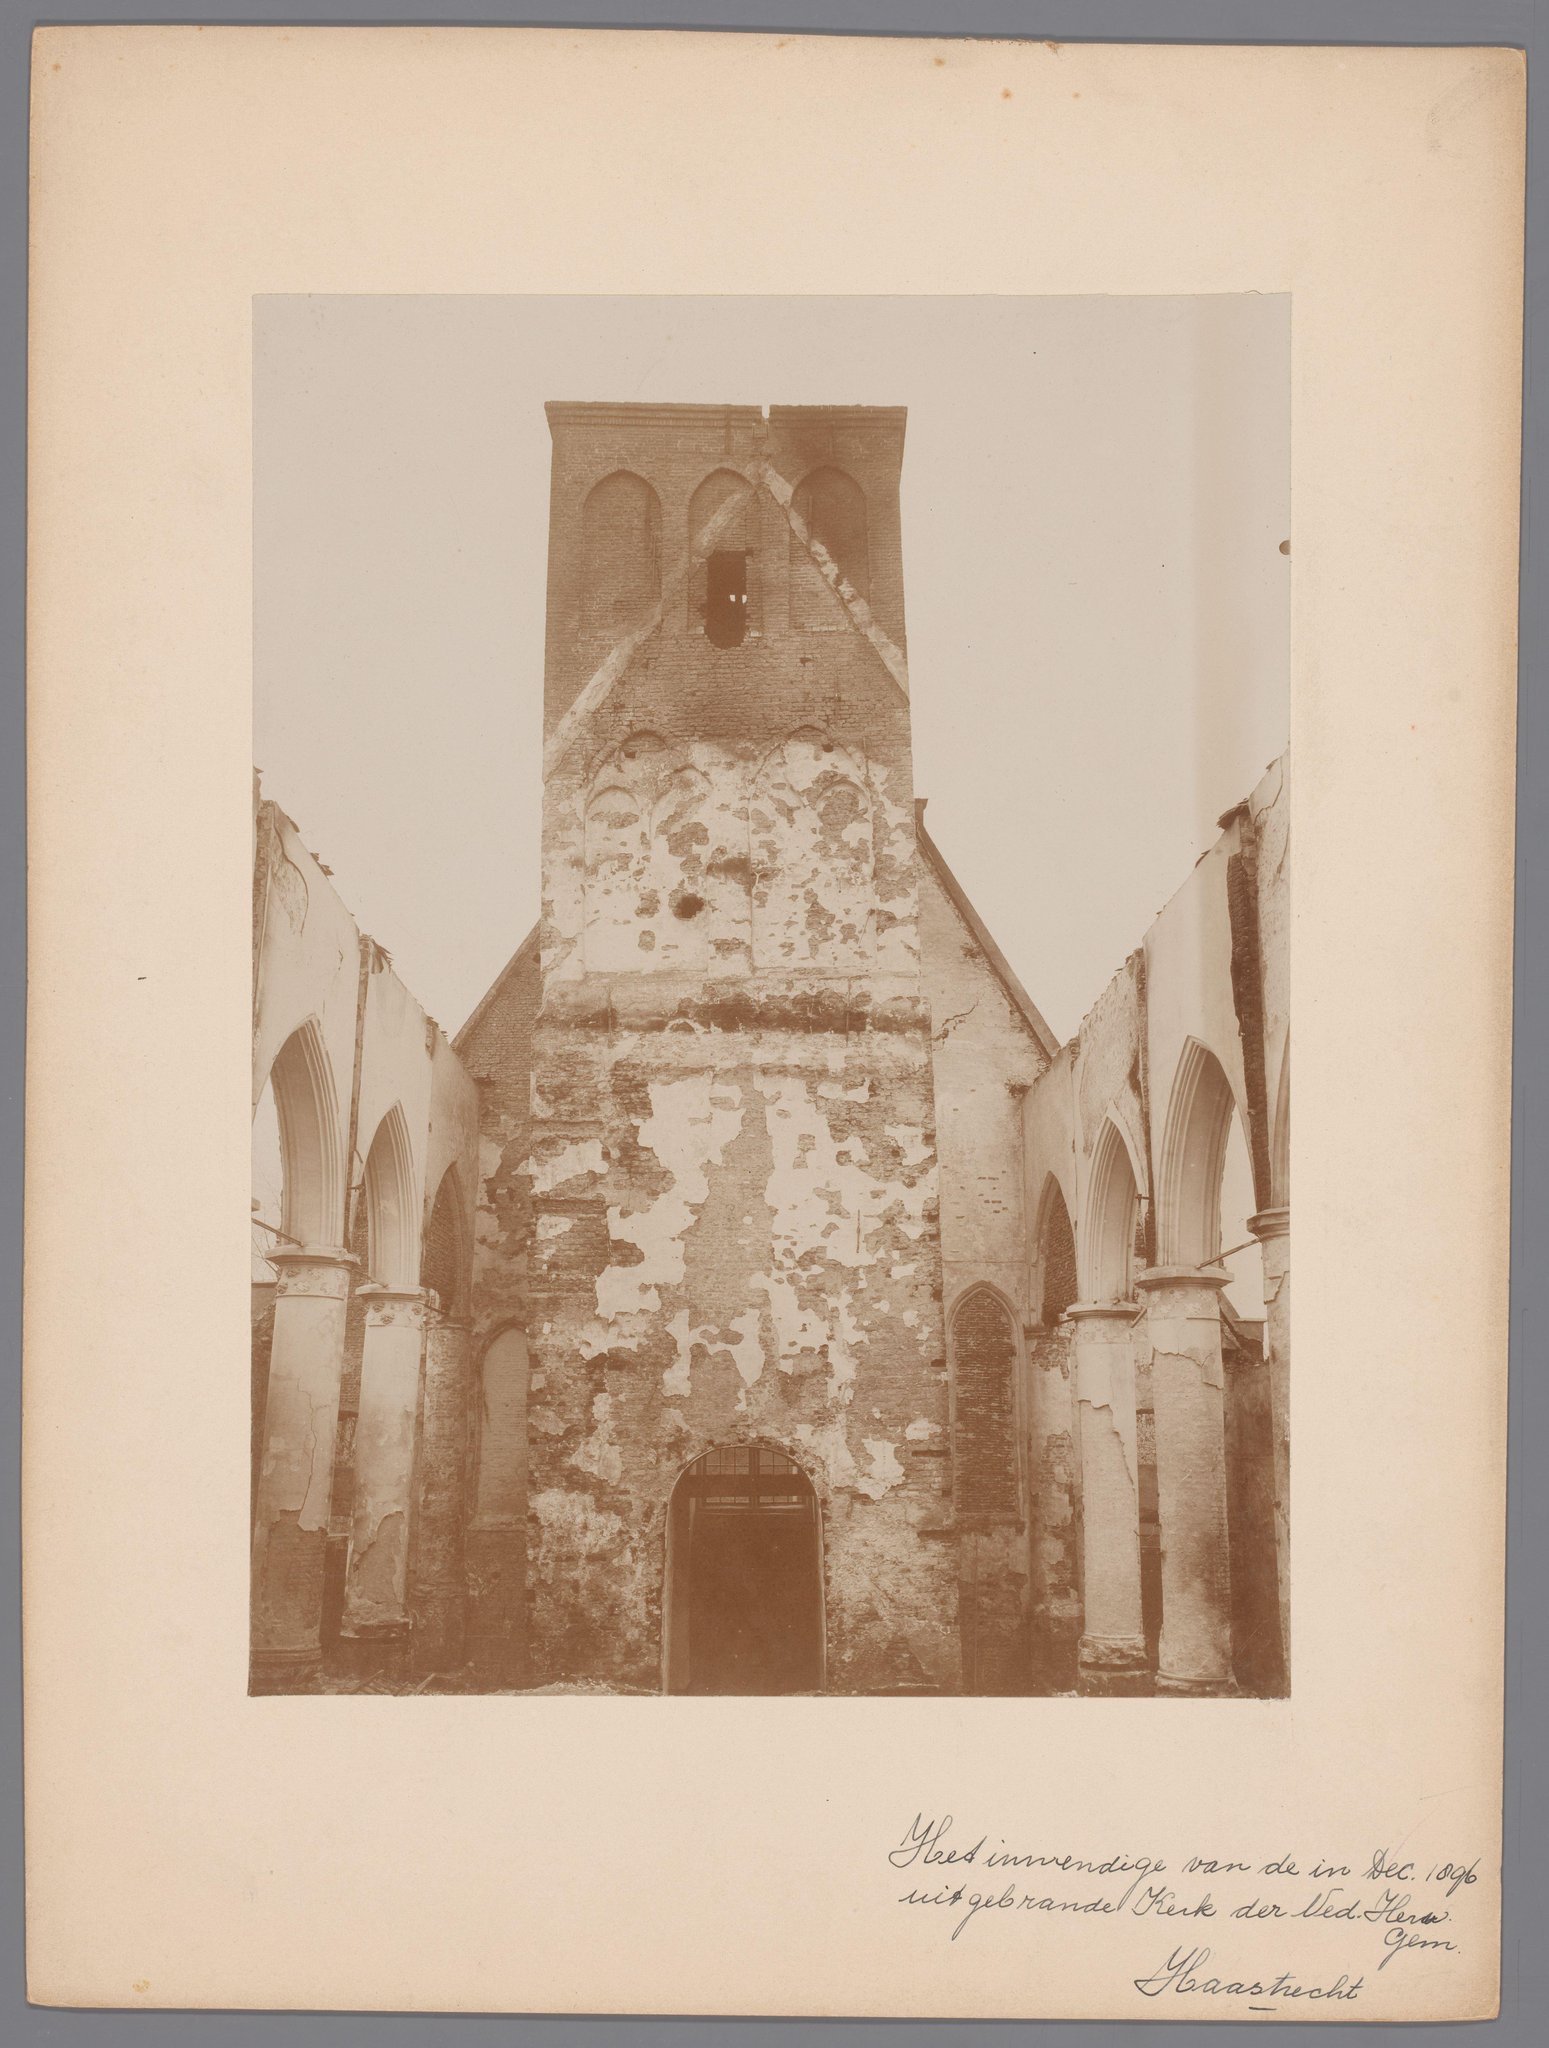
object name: photograph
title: Interieur van de uitgebrande Hervormde Kerk te Haastrecht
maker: anoniem (monumentenzorg)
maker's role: fotograaf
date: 1896-1900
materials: cardboard, photographic support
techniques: collodion silver print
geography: haastrecht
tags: interior of church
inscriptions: annotation: ‘Het inwendige van de in Dec. 1896 uitgebrande Kerk der Ned. Herv. gem./ Haastrecht’, annotation: ‘Haastrecht (Z.H.)/ 't inwendige van de in Dec 1896 uitgebrande kerk der Ned Herv gem.’